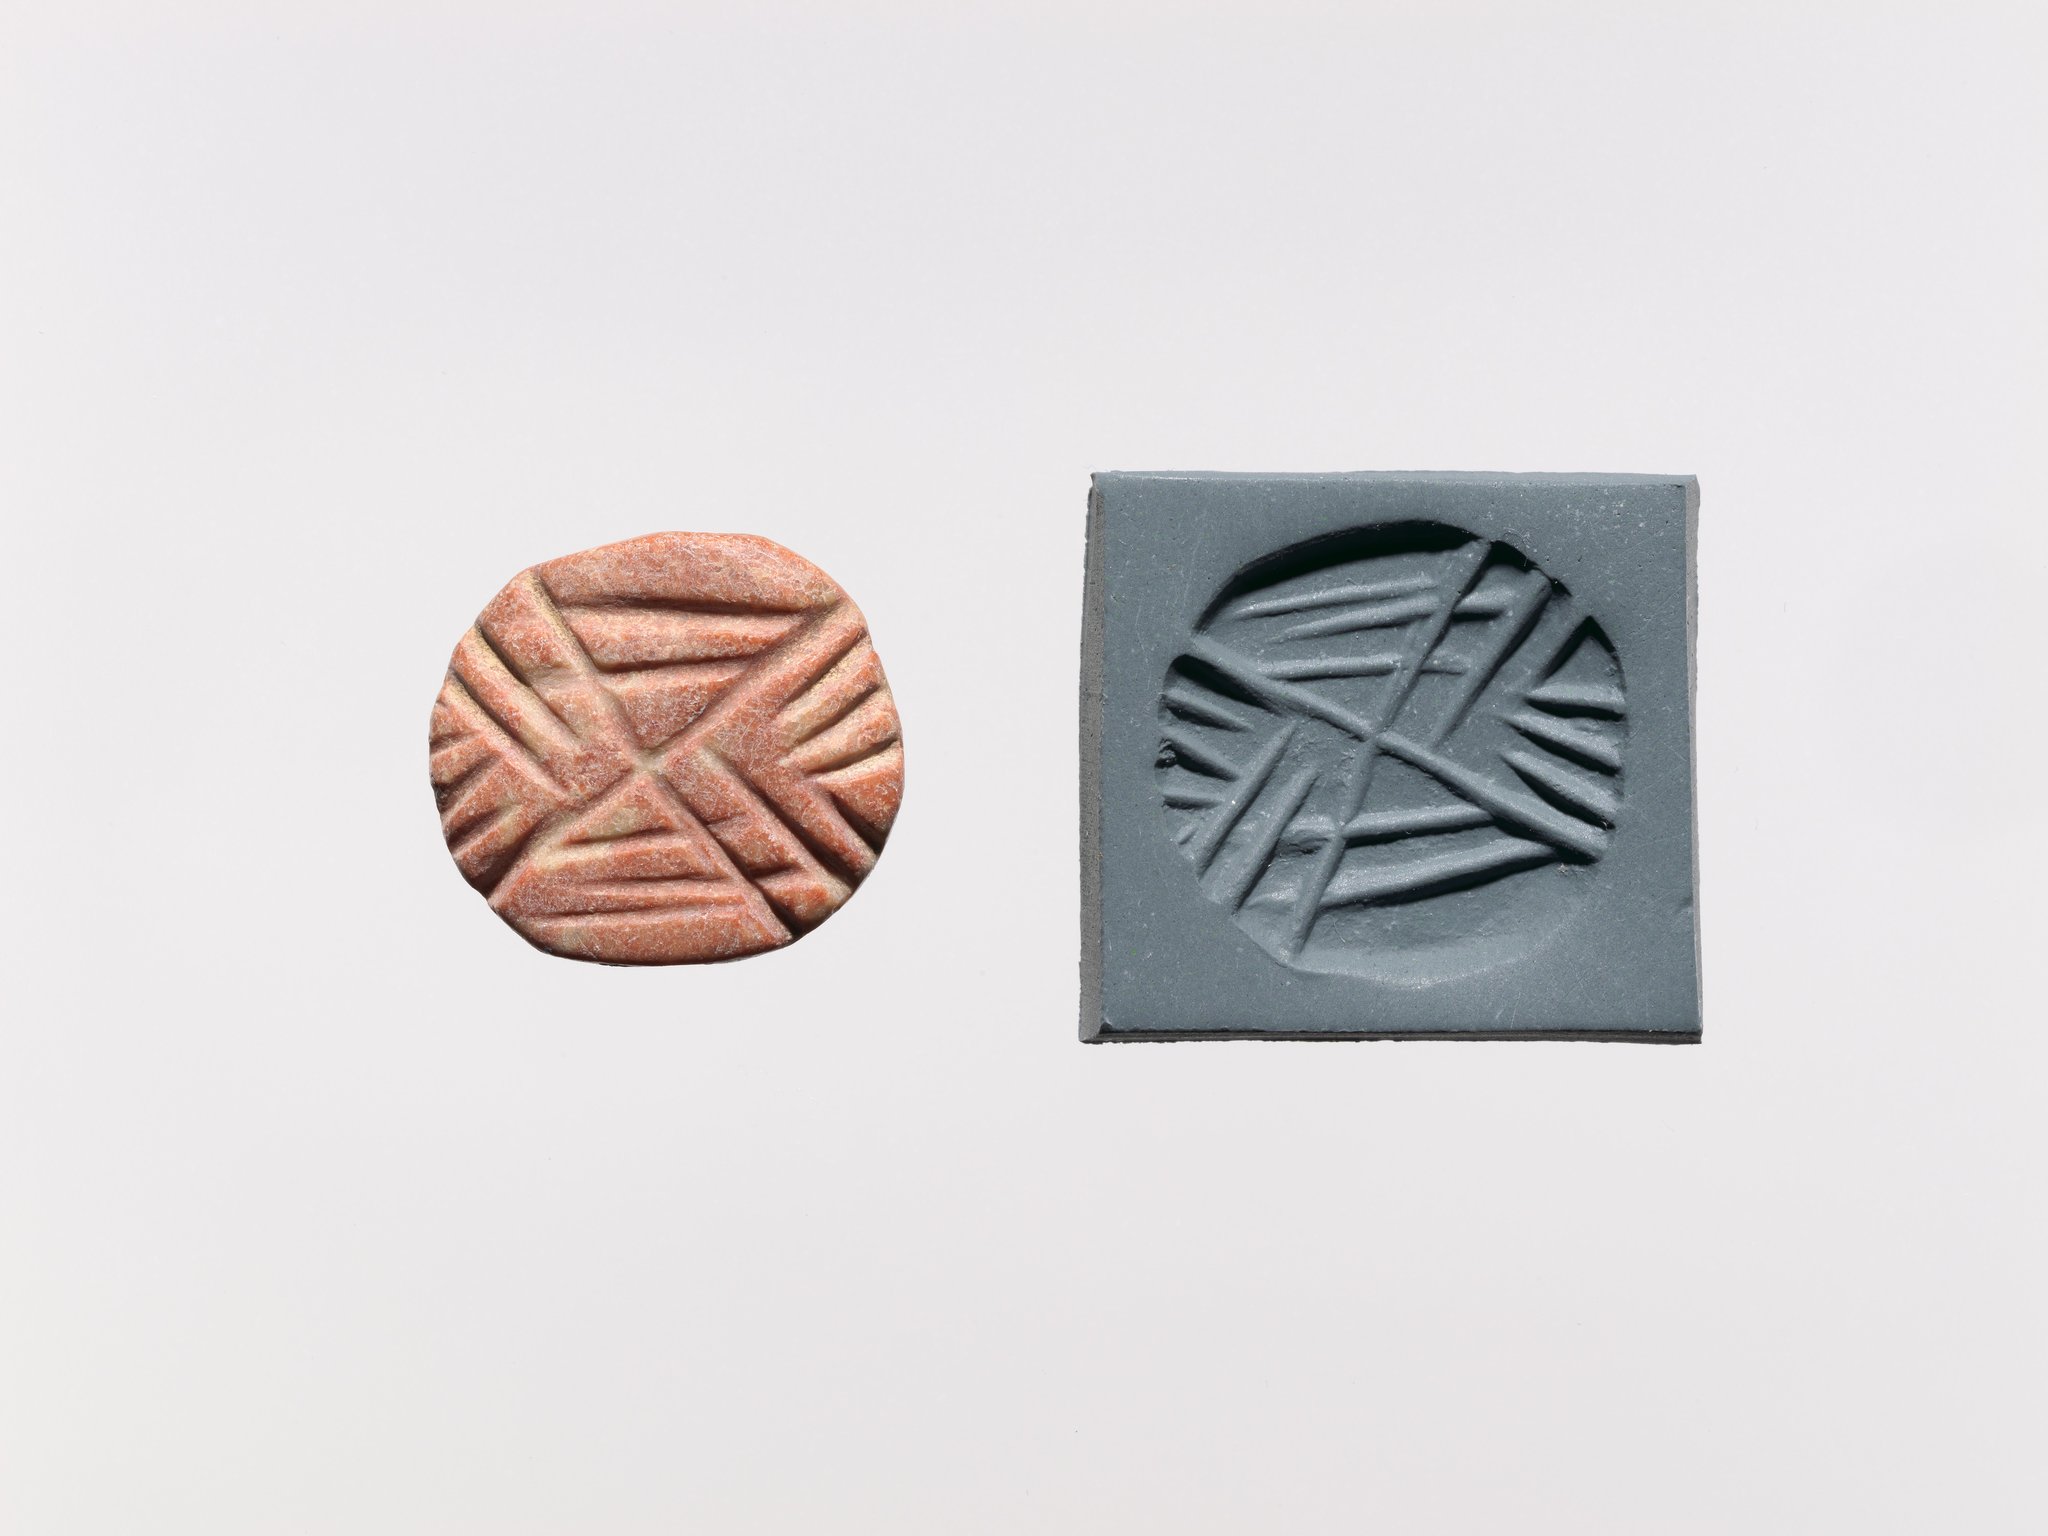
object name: stamp seal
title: Lentoid seal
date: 4500-3600 BCE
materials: stone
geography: mesopotamia